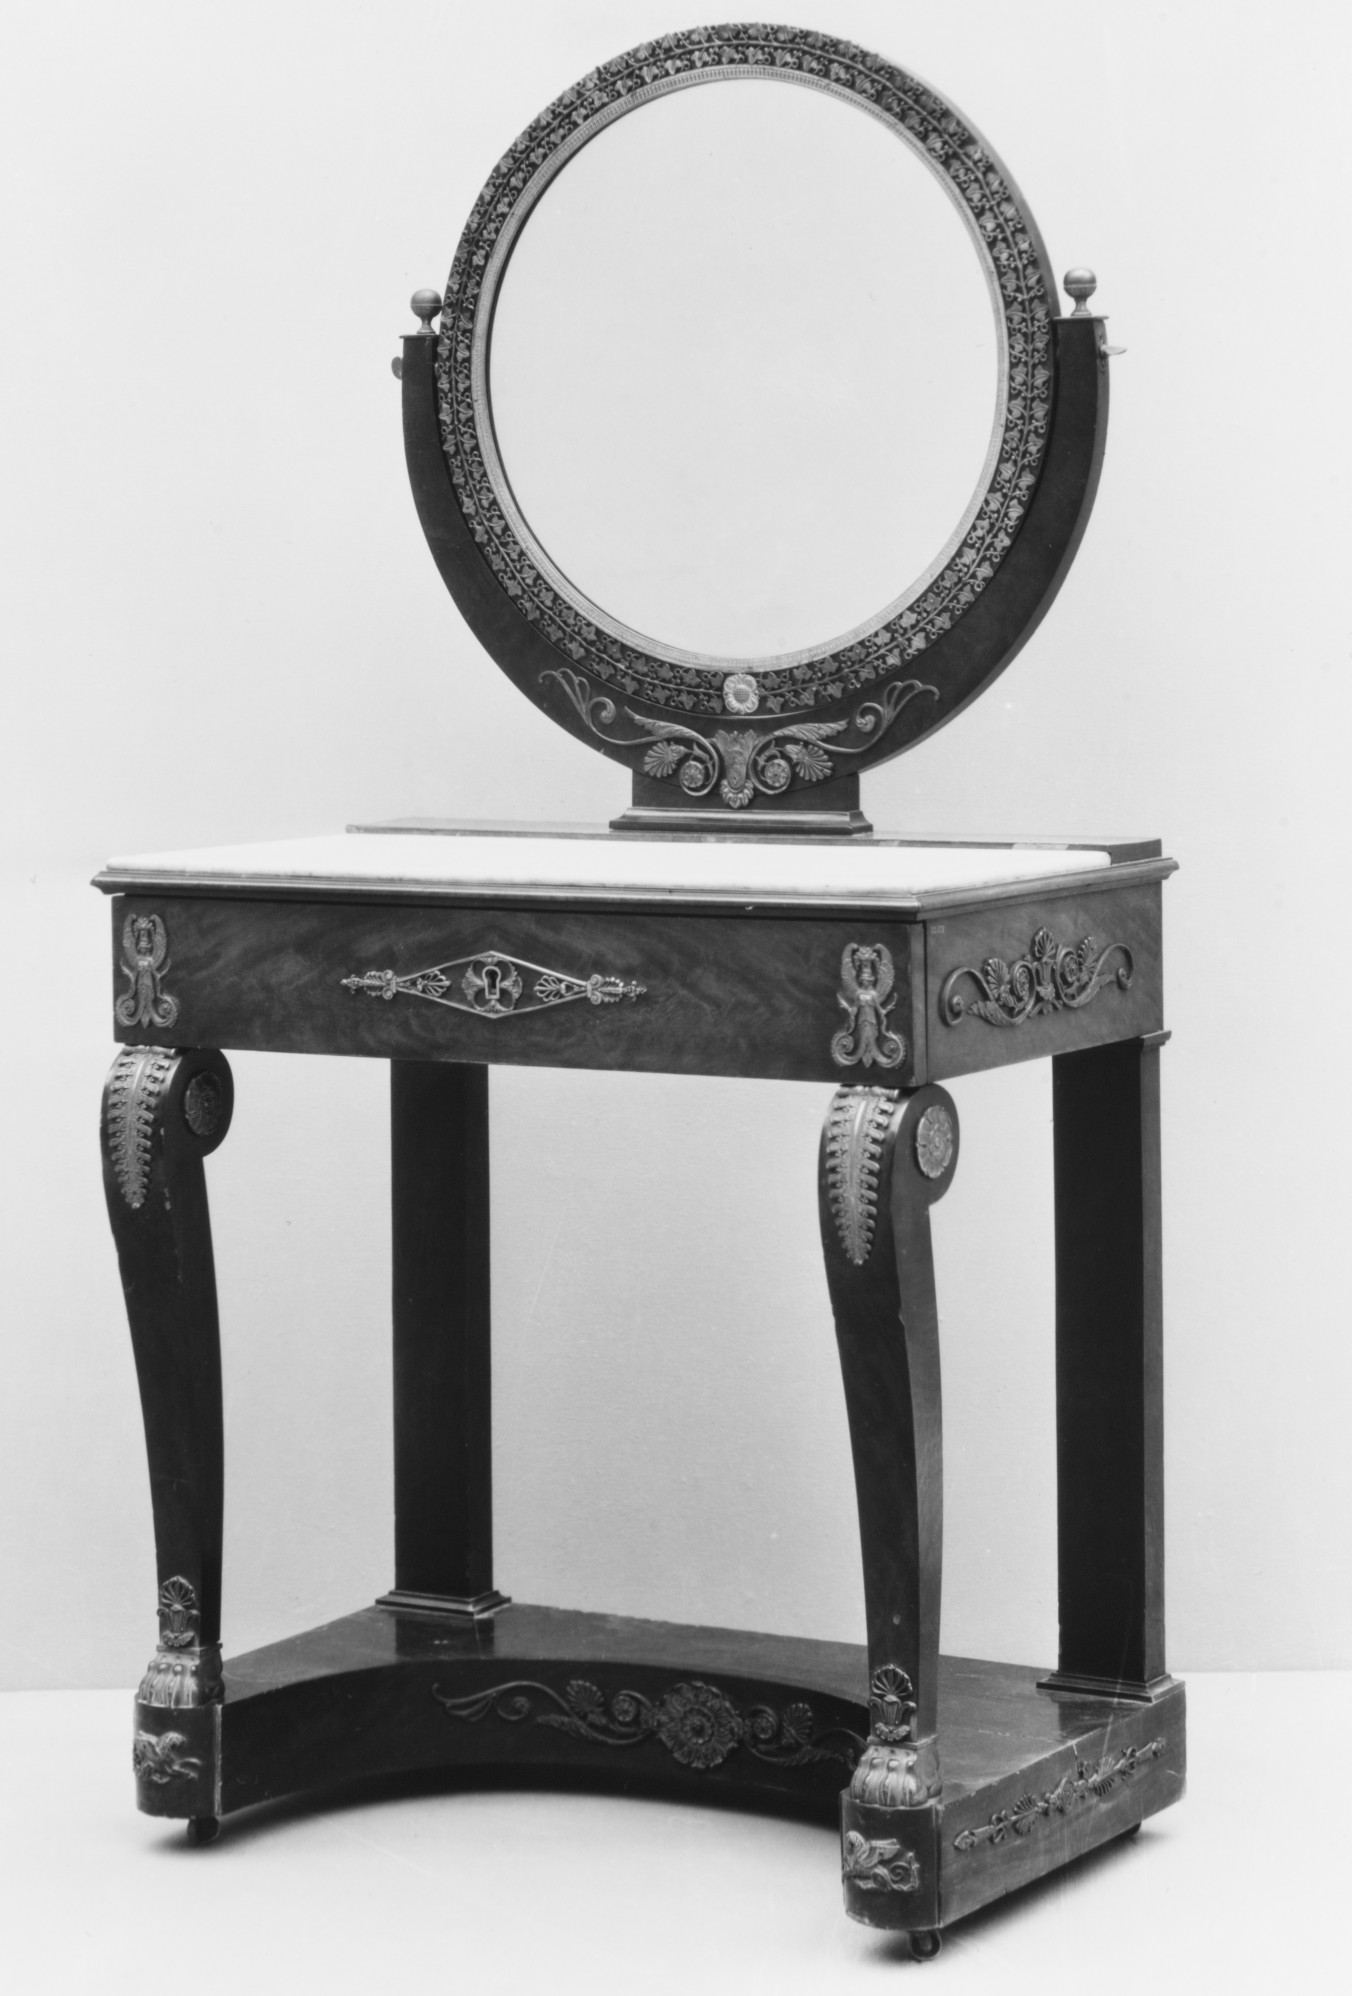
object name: dressing table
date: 1815-1830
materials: gilt bronze, wood, marble